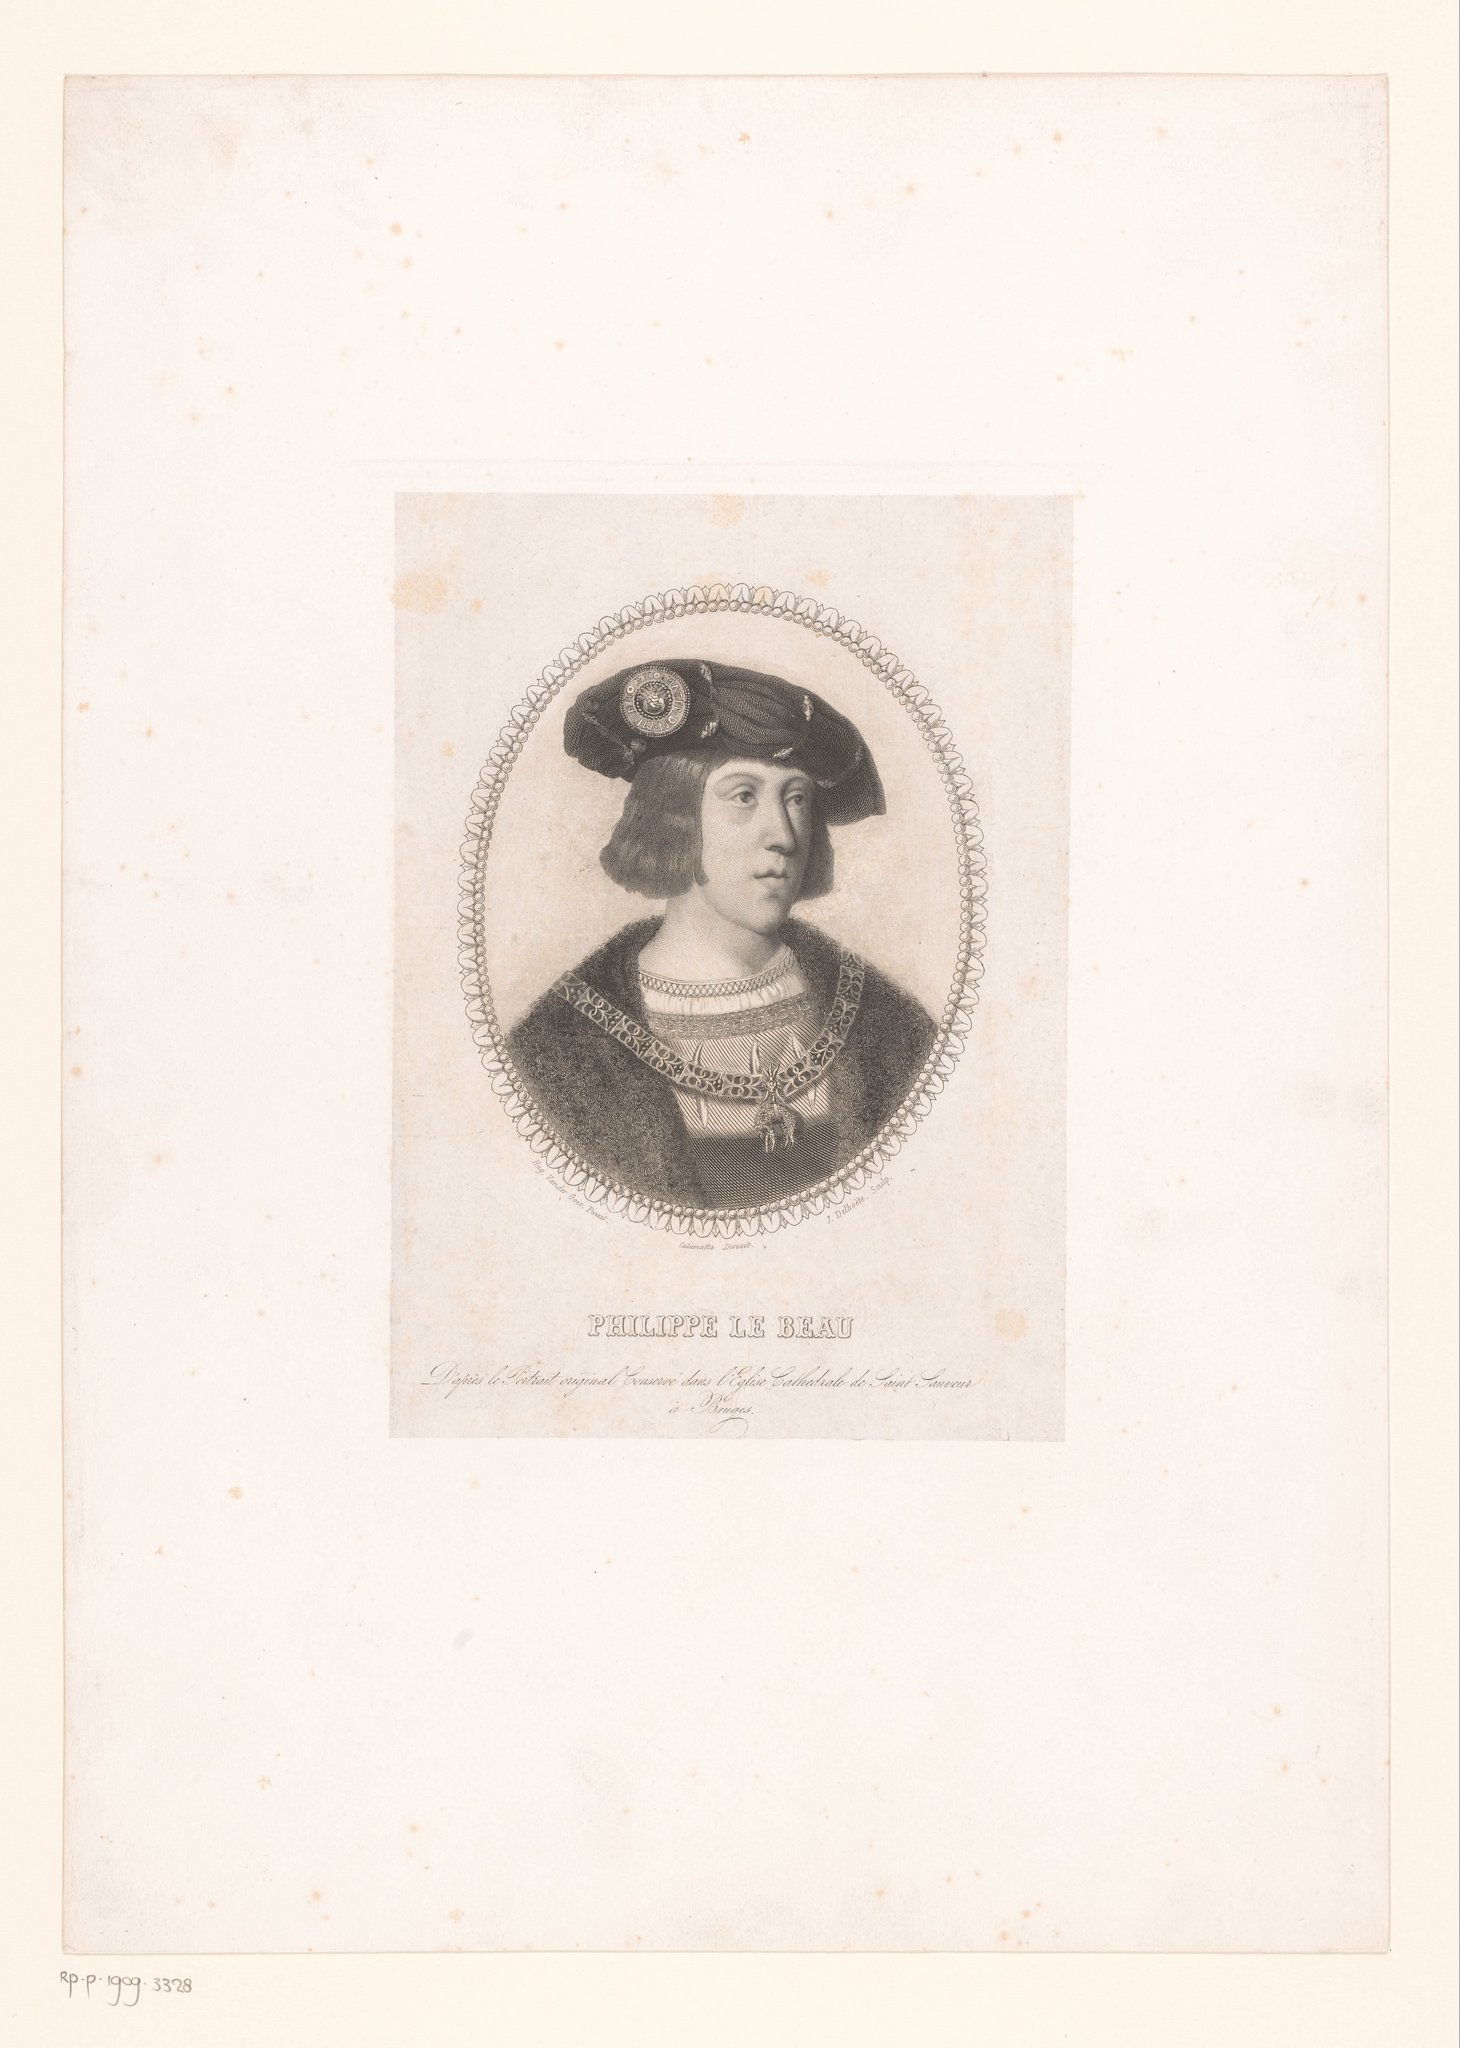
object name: print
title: Philippe le Beau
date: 1835-1875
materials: paper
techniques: engraving, etching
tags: filips de schone (hertog van bourgondië), historical person (...) - historical person (...) portrayed alone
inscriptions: collector's mark: Lugt 2228